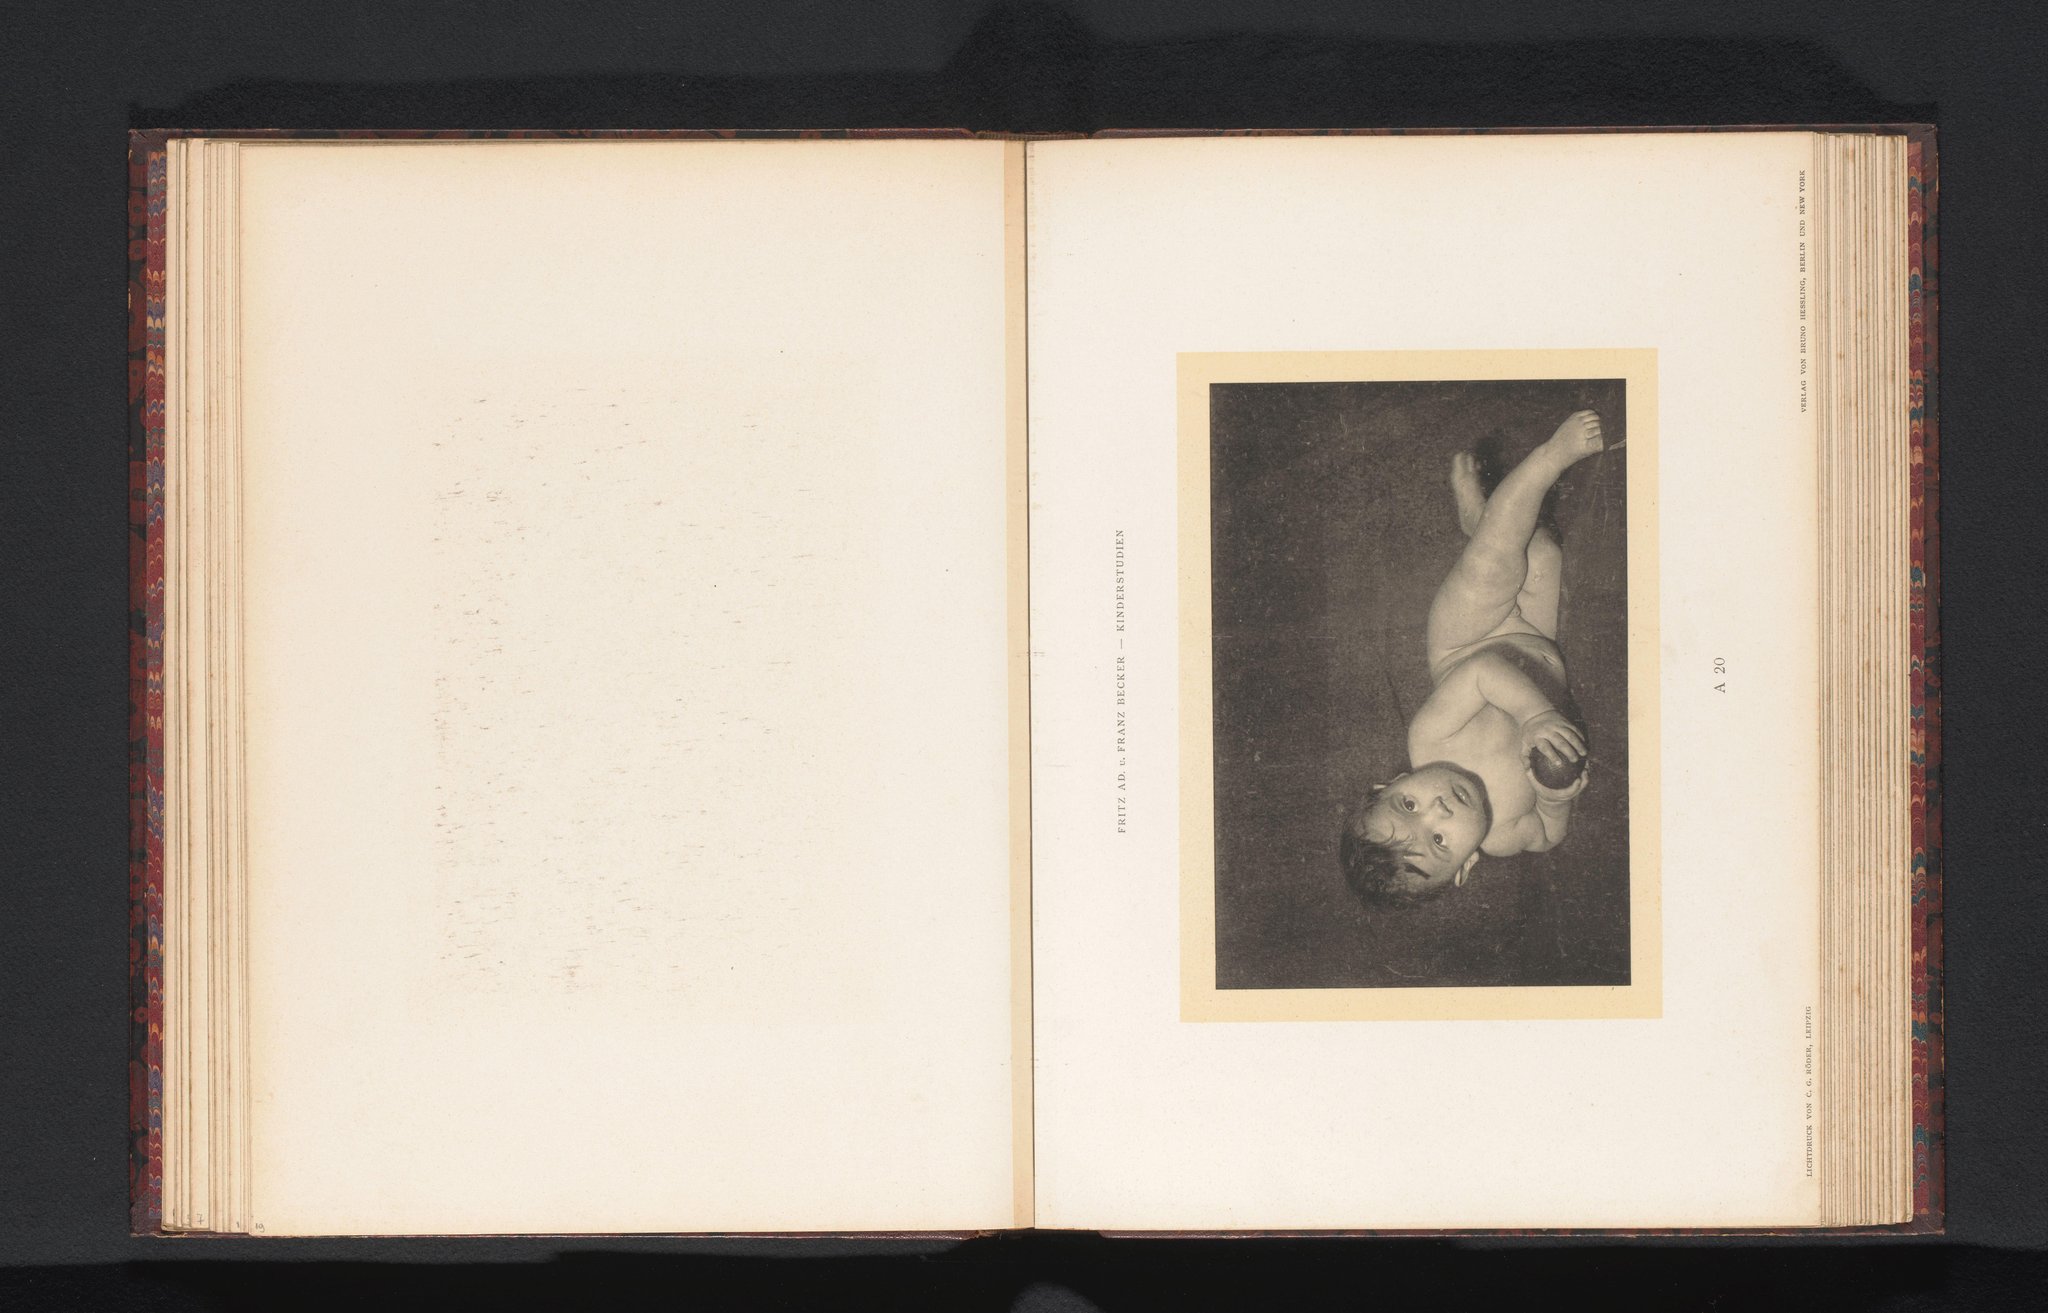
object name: photomechanical print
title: Liggende naakte jongen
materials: paper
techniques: photograph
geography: leipzig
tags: toddler (male), lying on one side, with uplifted upper part of the body and leaning on the arm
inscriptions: number: ‘A 20’